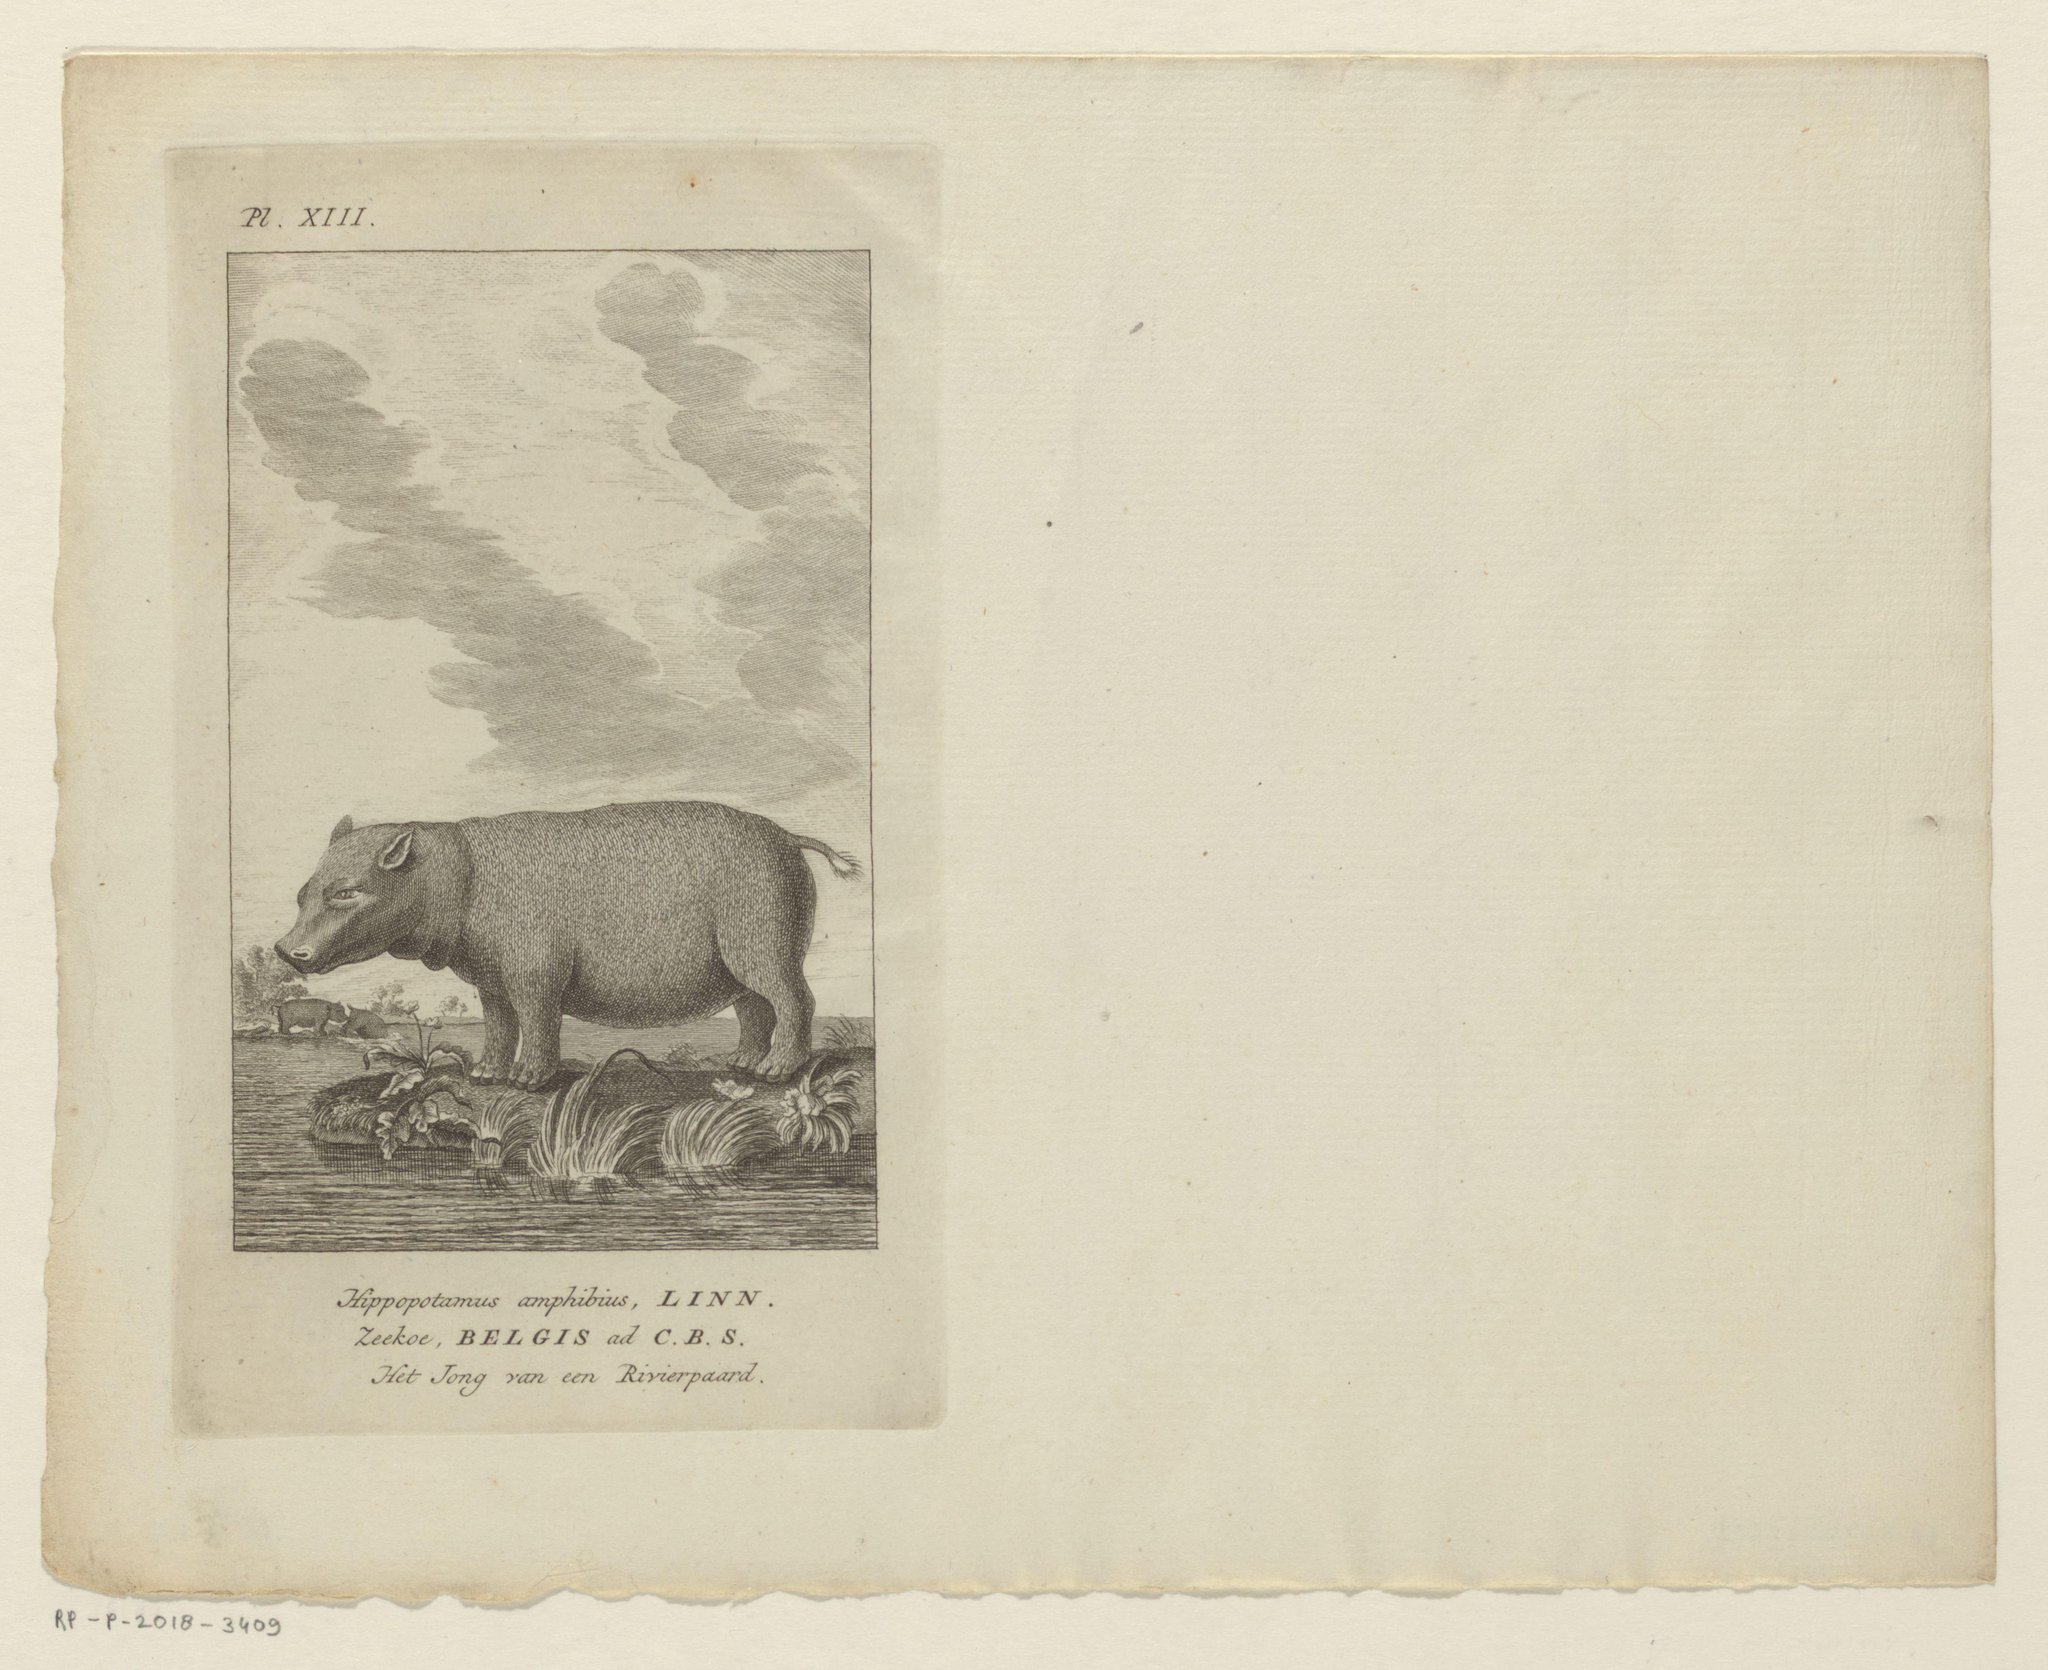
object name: book illustration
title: Jong van een nijlpaard aan de waterkant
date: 1787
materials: paper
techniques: engraving, etching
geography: netherlands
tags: hoofed animals: hippopotamus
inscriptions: watermark, collector's mark: Lugt 2228